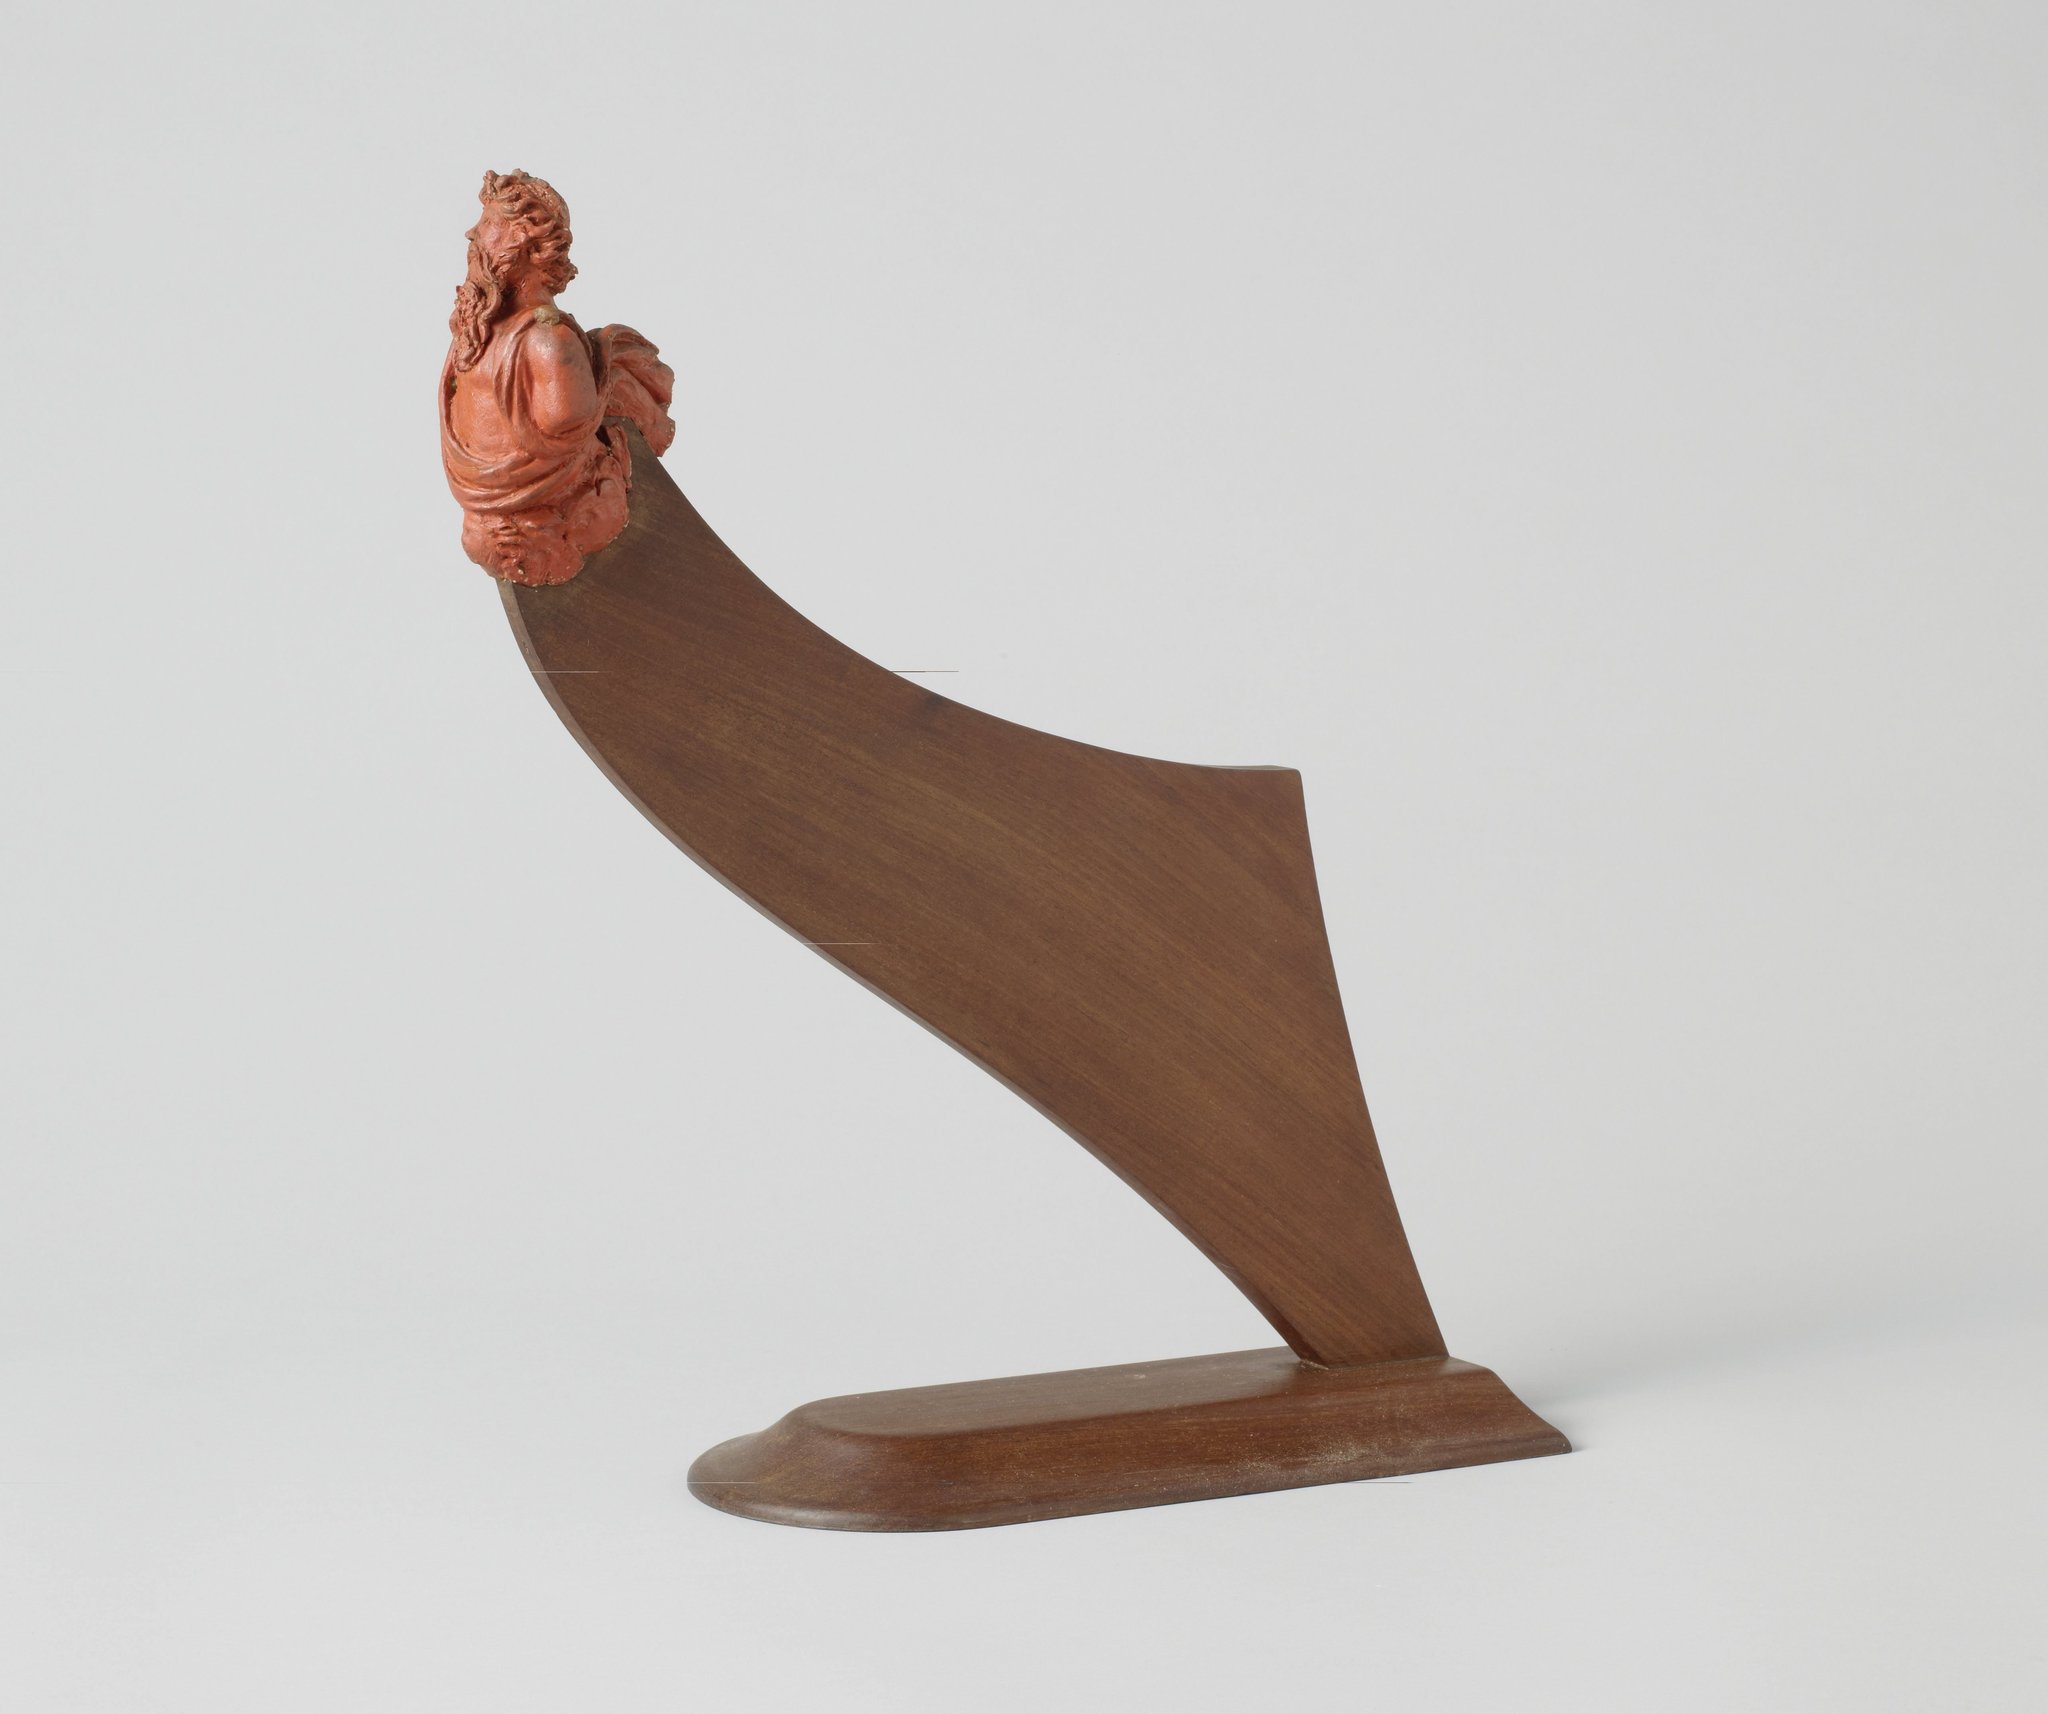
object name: scale model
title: Model of a figurehead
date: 1820-1830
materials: wax, wood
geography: flushing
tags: (story of) boreas (aquilo), the north wind; 'borea overo aquilone' (ripa)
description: Model van rode was van een schegbeeld op een scheg, op een voetstuk. Het beeld stelt de torso van een gekroonde man in klassieke klederdracht voor, met een masker onder het torso. Het stelt Boreas voor, de Griekse god van de noordenwind.